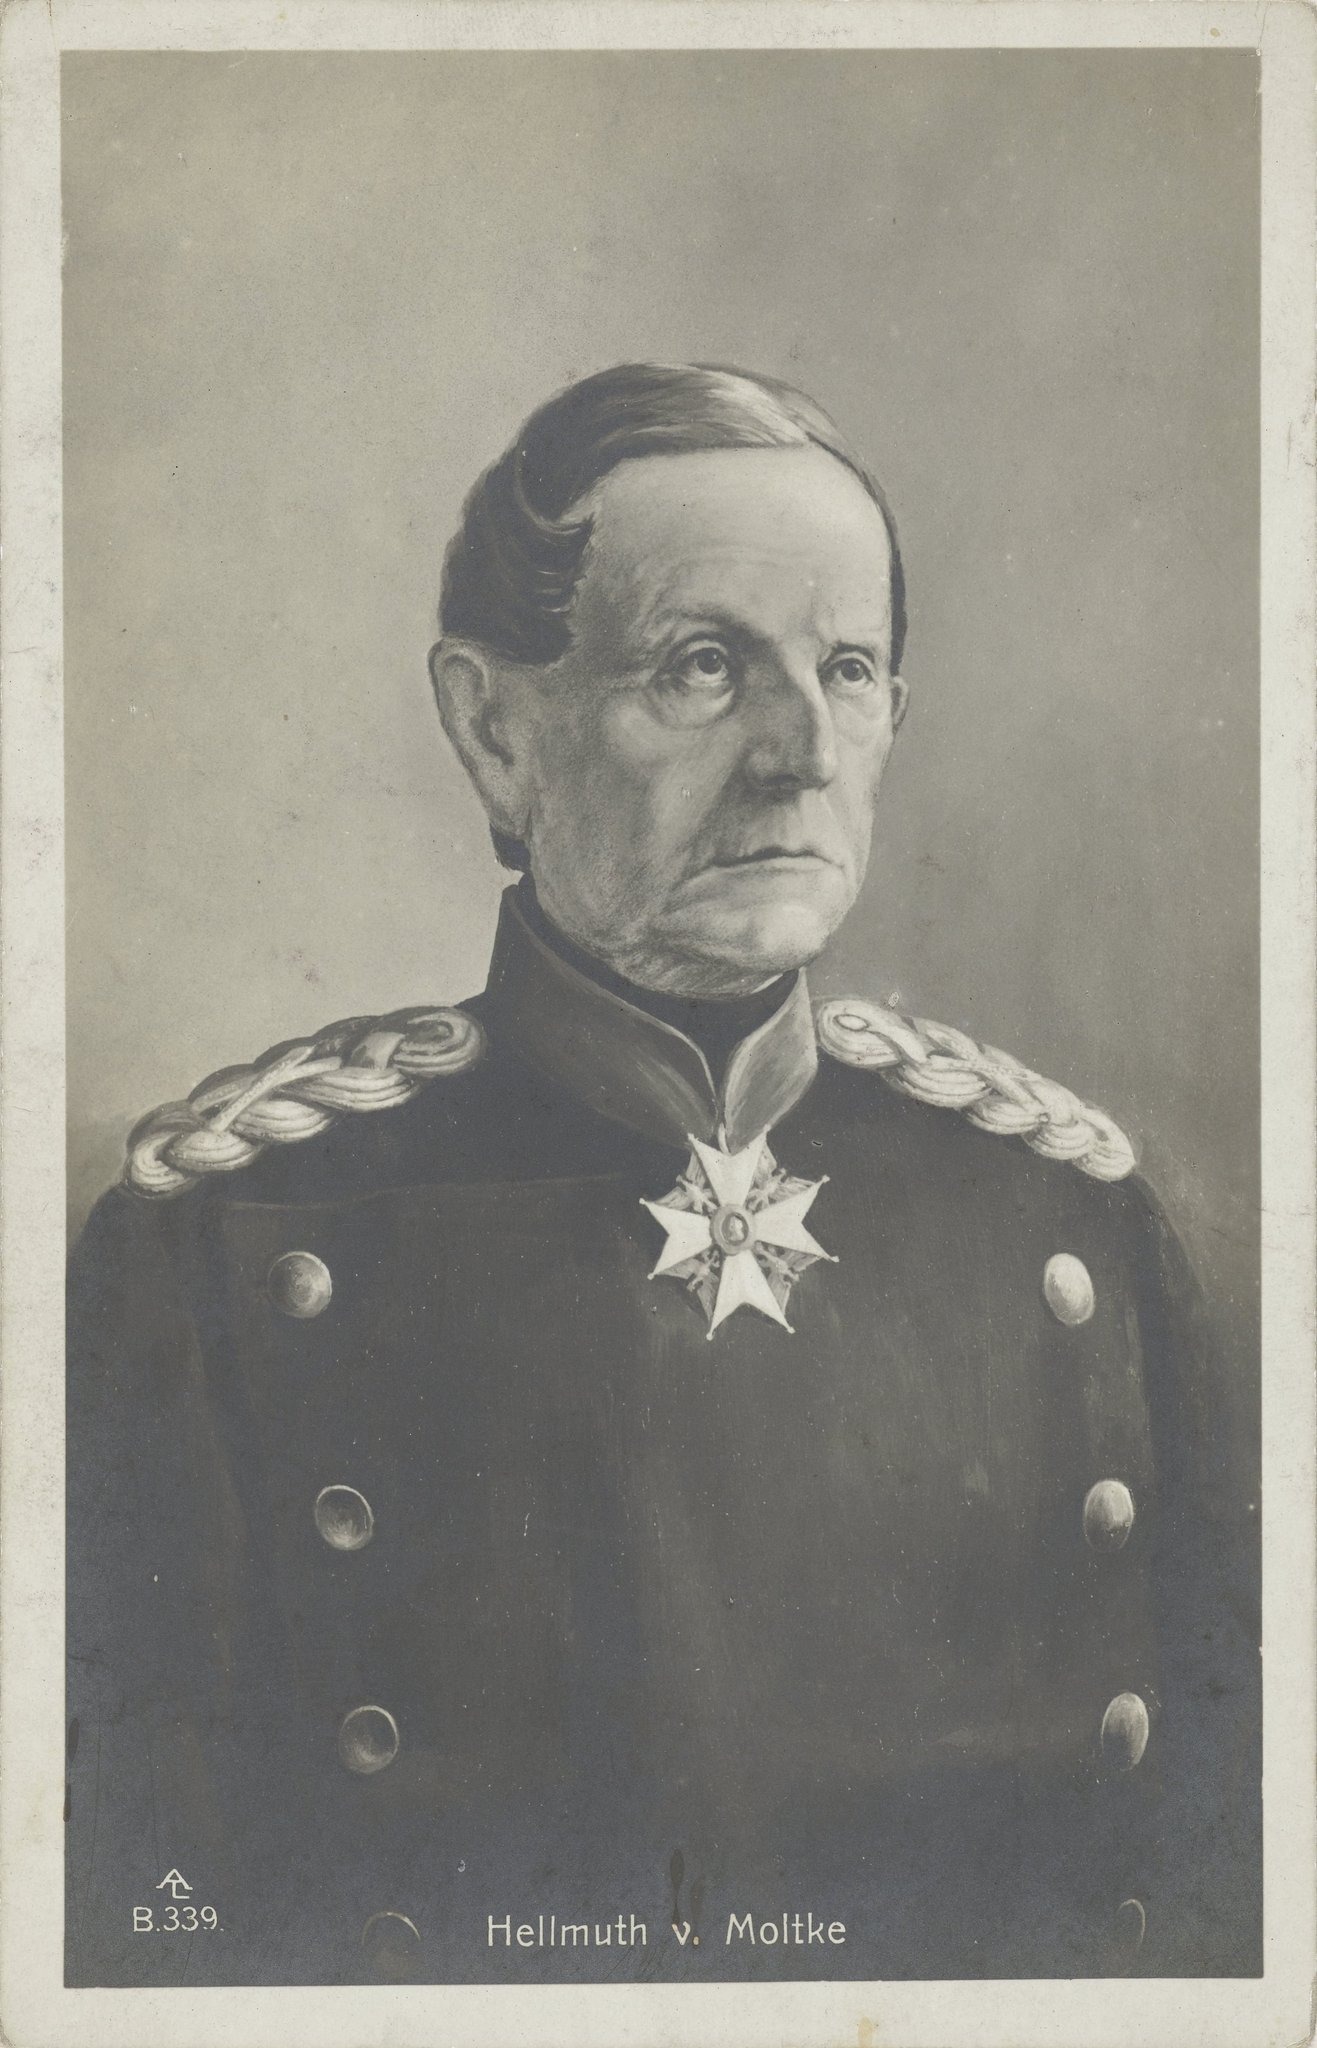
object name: photograph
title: Hellmuth von Moltke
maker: Anonymous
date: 1880-1940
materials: photographic support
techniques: gelatin silver print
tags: berlin